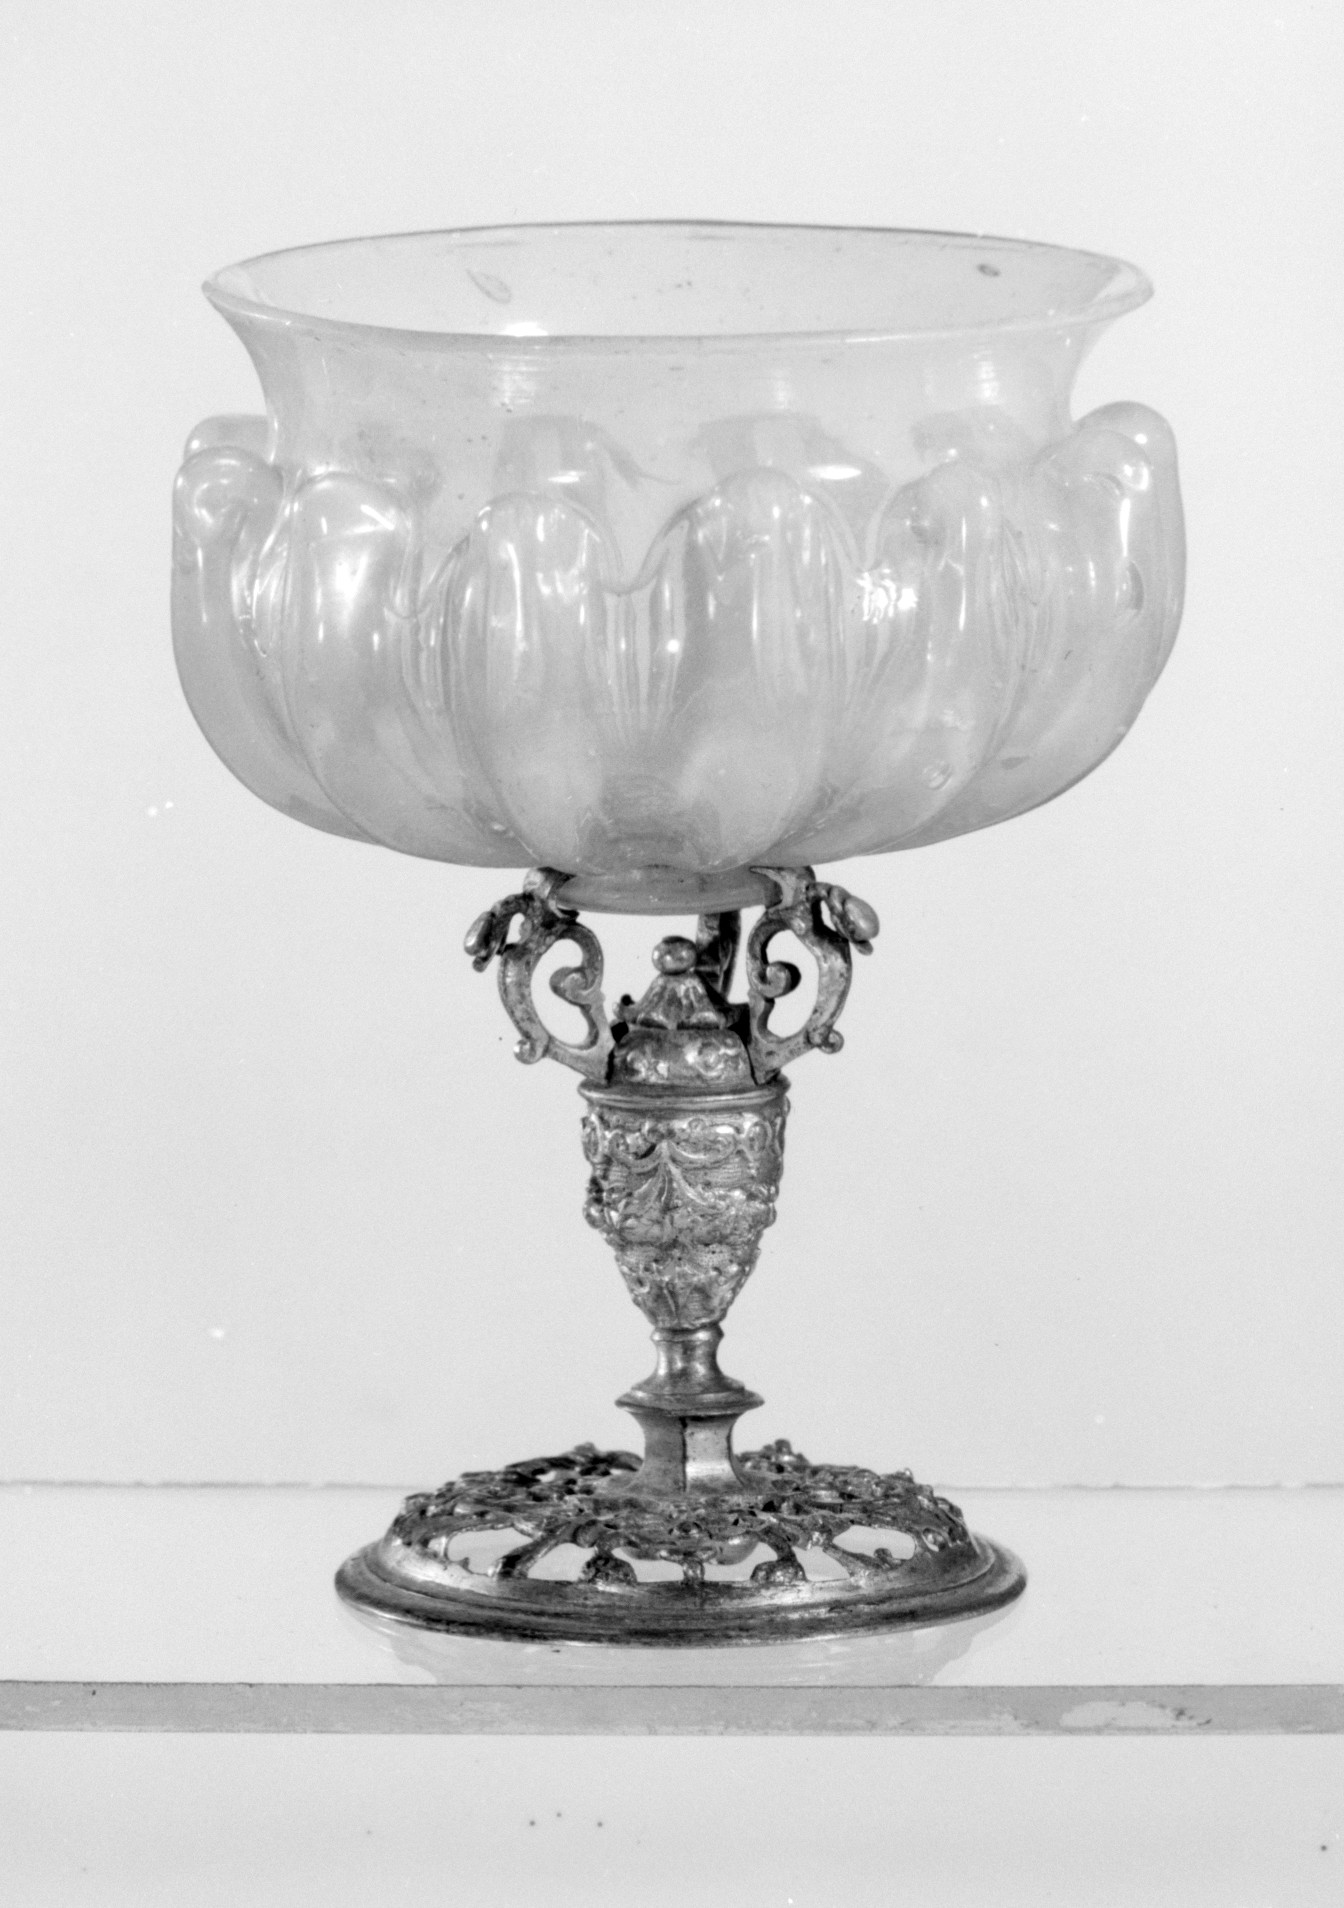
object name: goblet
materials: gilt bronze, glass